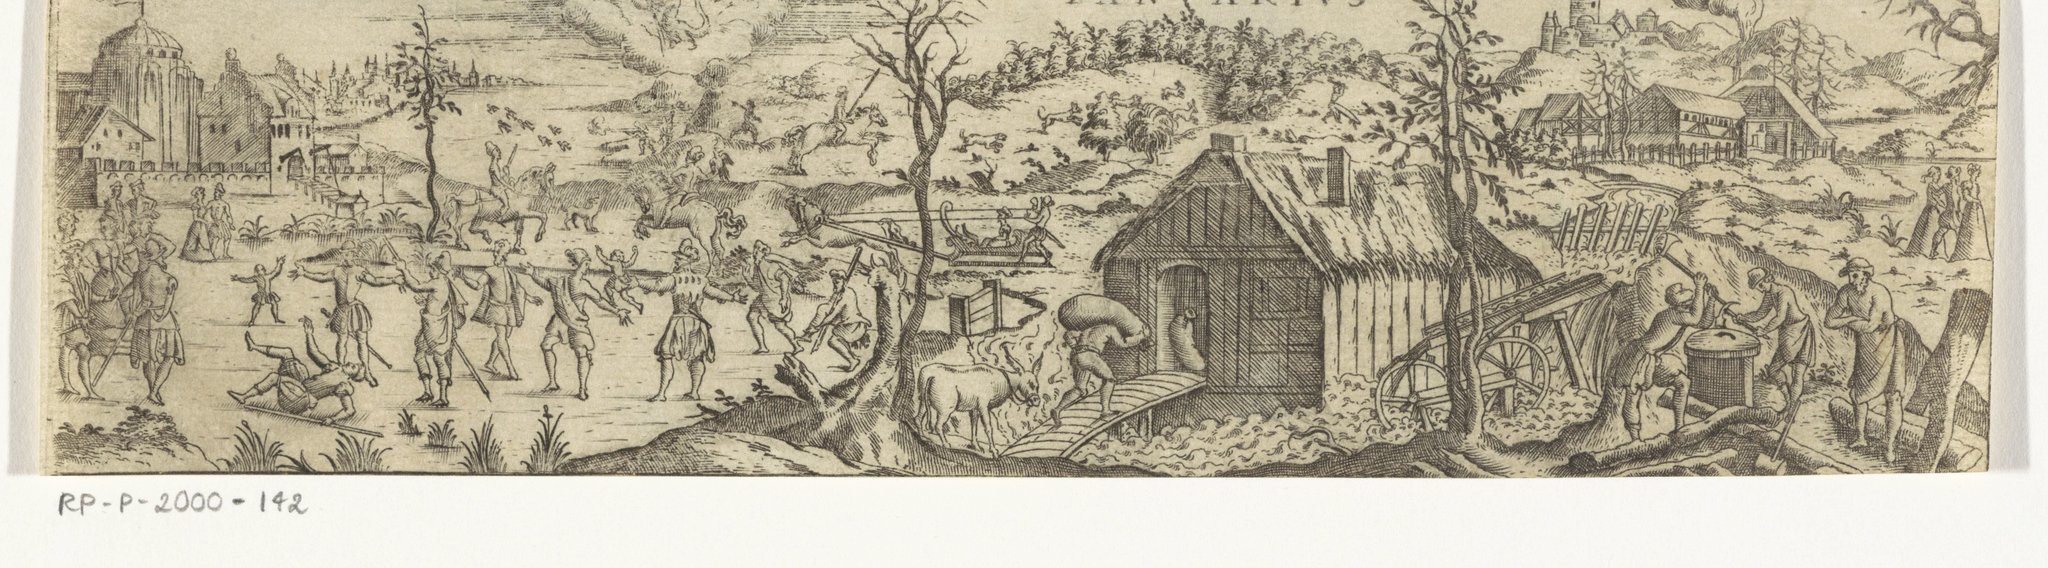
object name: print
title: Ianuarius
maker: Anonymous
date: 1554-1641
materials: paper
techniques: etching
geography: netherlands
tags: january and its 'labours' (+ with zodiacal signs)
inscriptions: collector's mark: Lugt 2760, collector's mark: Lugt 2228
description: De werkzaamheden van de maand januari. Links ijsvermaak met schaatsers en slederijders. In het midden wordt een schuur gevuld met zakken en rechts wordt hout gehakt. In de lucht het dierenriemteken Waterman.